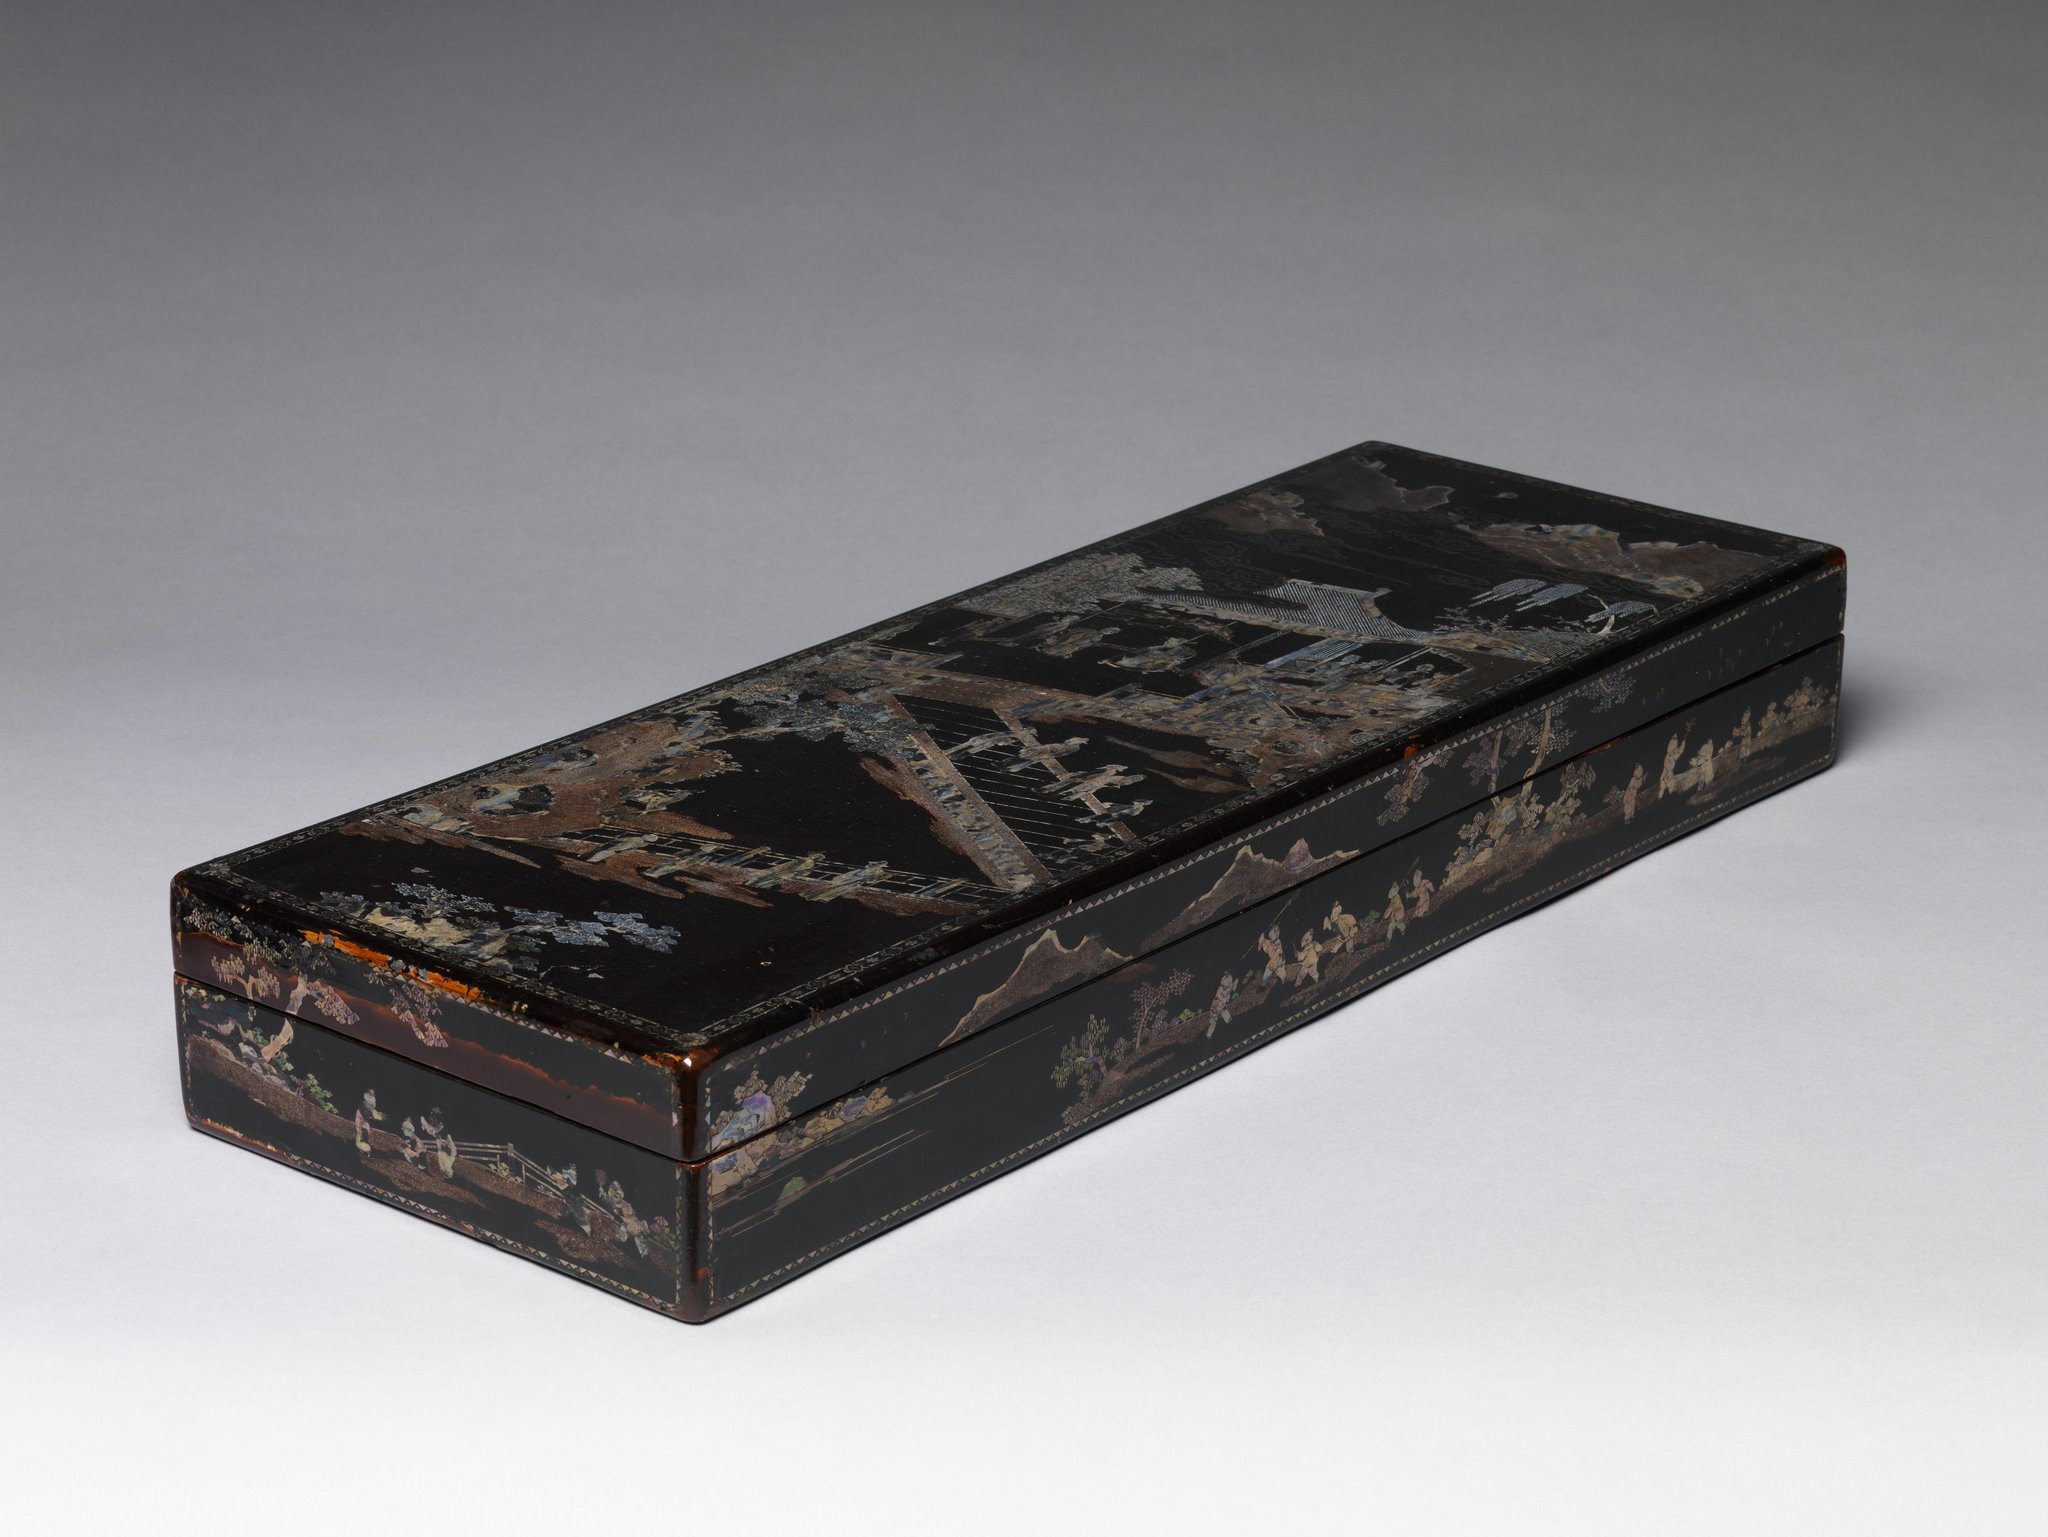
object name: covered box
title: Box with scene of a reception and boys at play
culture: chinese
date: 1601-1700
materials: gold, lacquer, mother of pearl, silver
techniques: inlay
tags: houses,boys,playing,trees